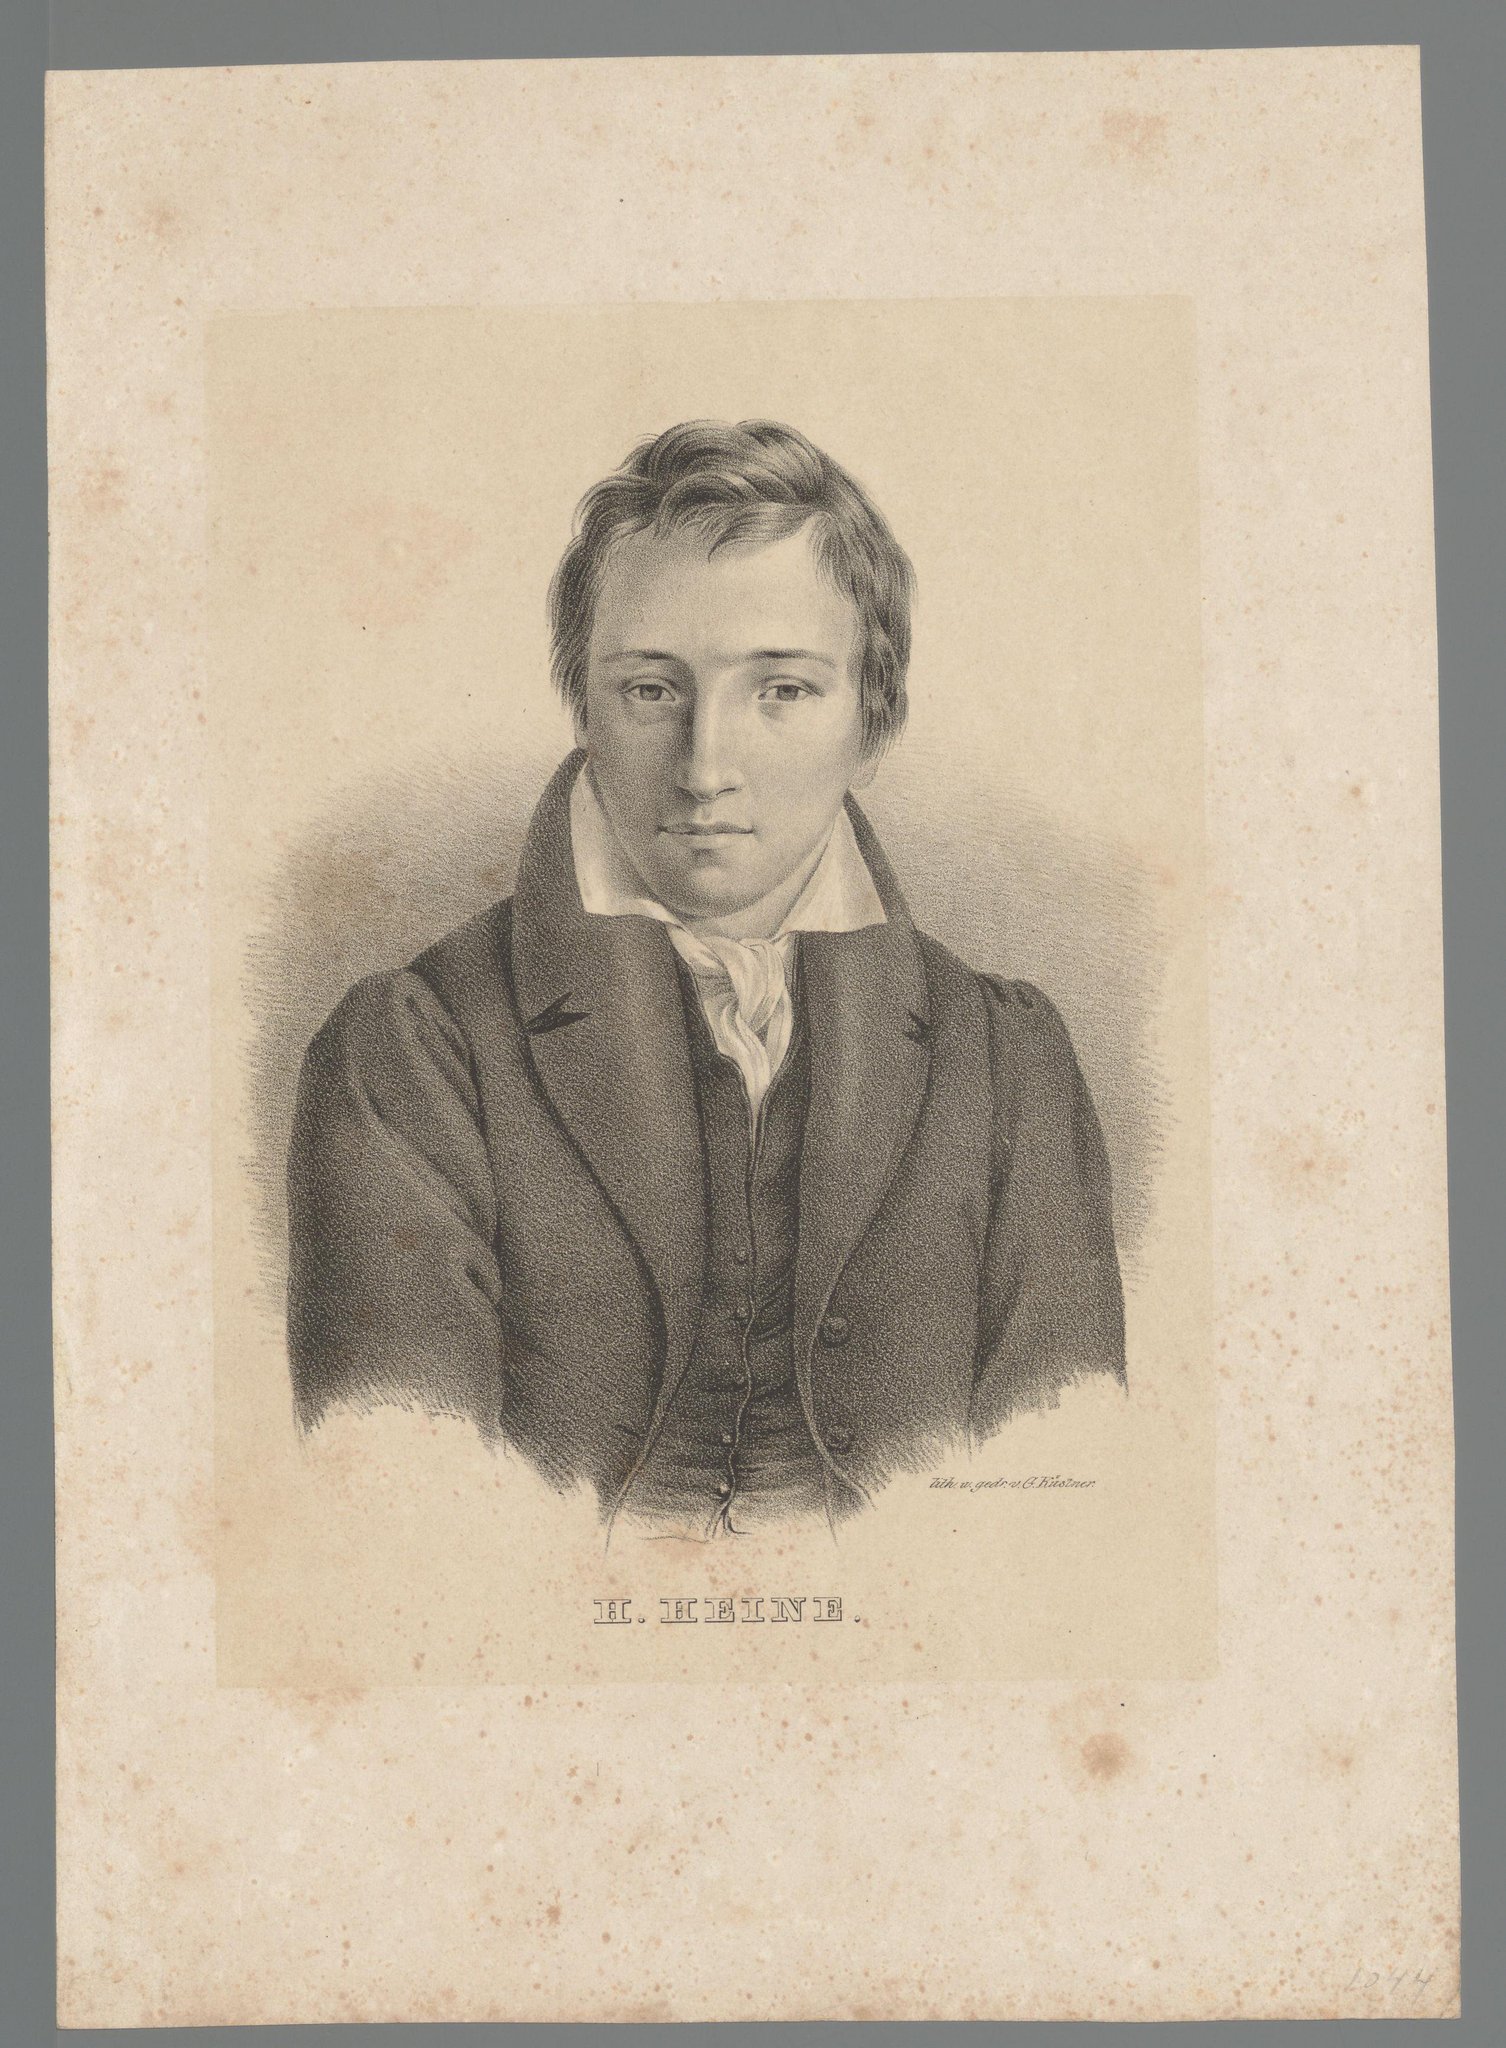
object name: print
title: Portret van Heinrich Heine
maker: gottfried küstner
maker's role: print maker, printer, publisher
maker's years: 1800-1864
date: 1810-1864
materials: paper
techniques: tone lithography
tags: paris, heinrich heine, historical persons, portrait of a writer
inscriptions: collector's mark: Lugt 2228